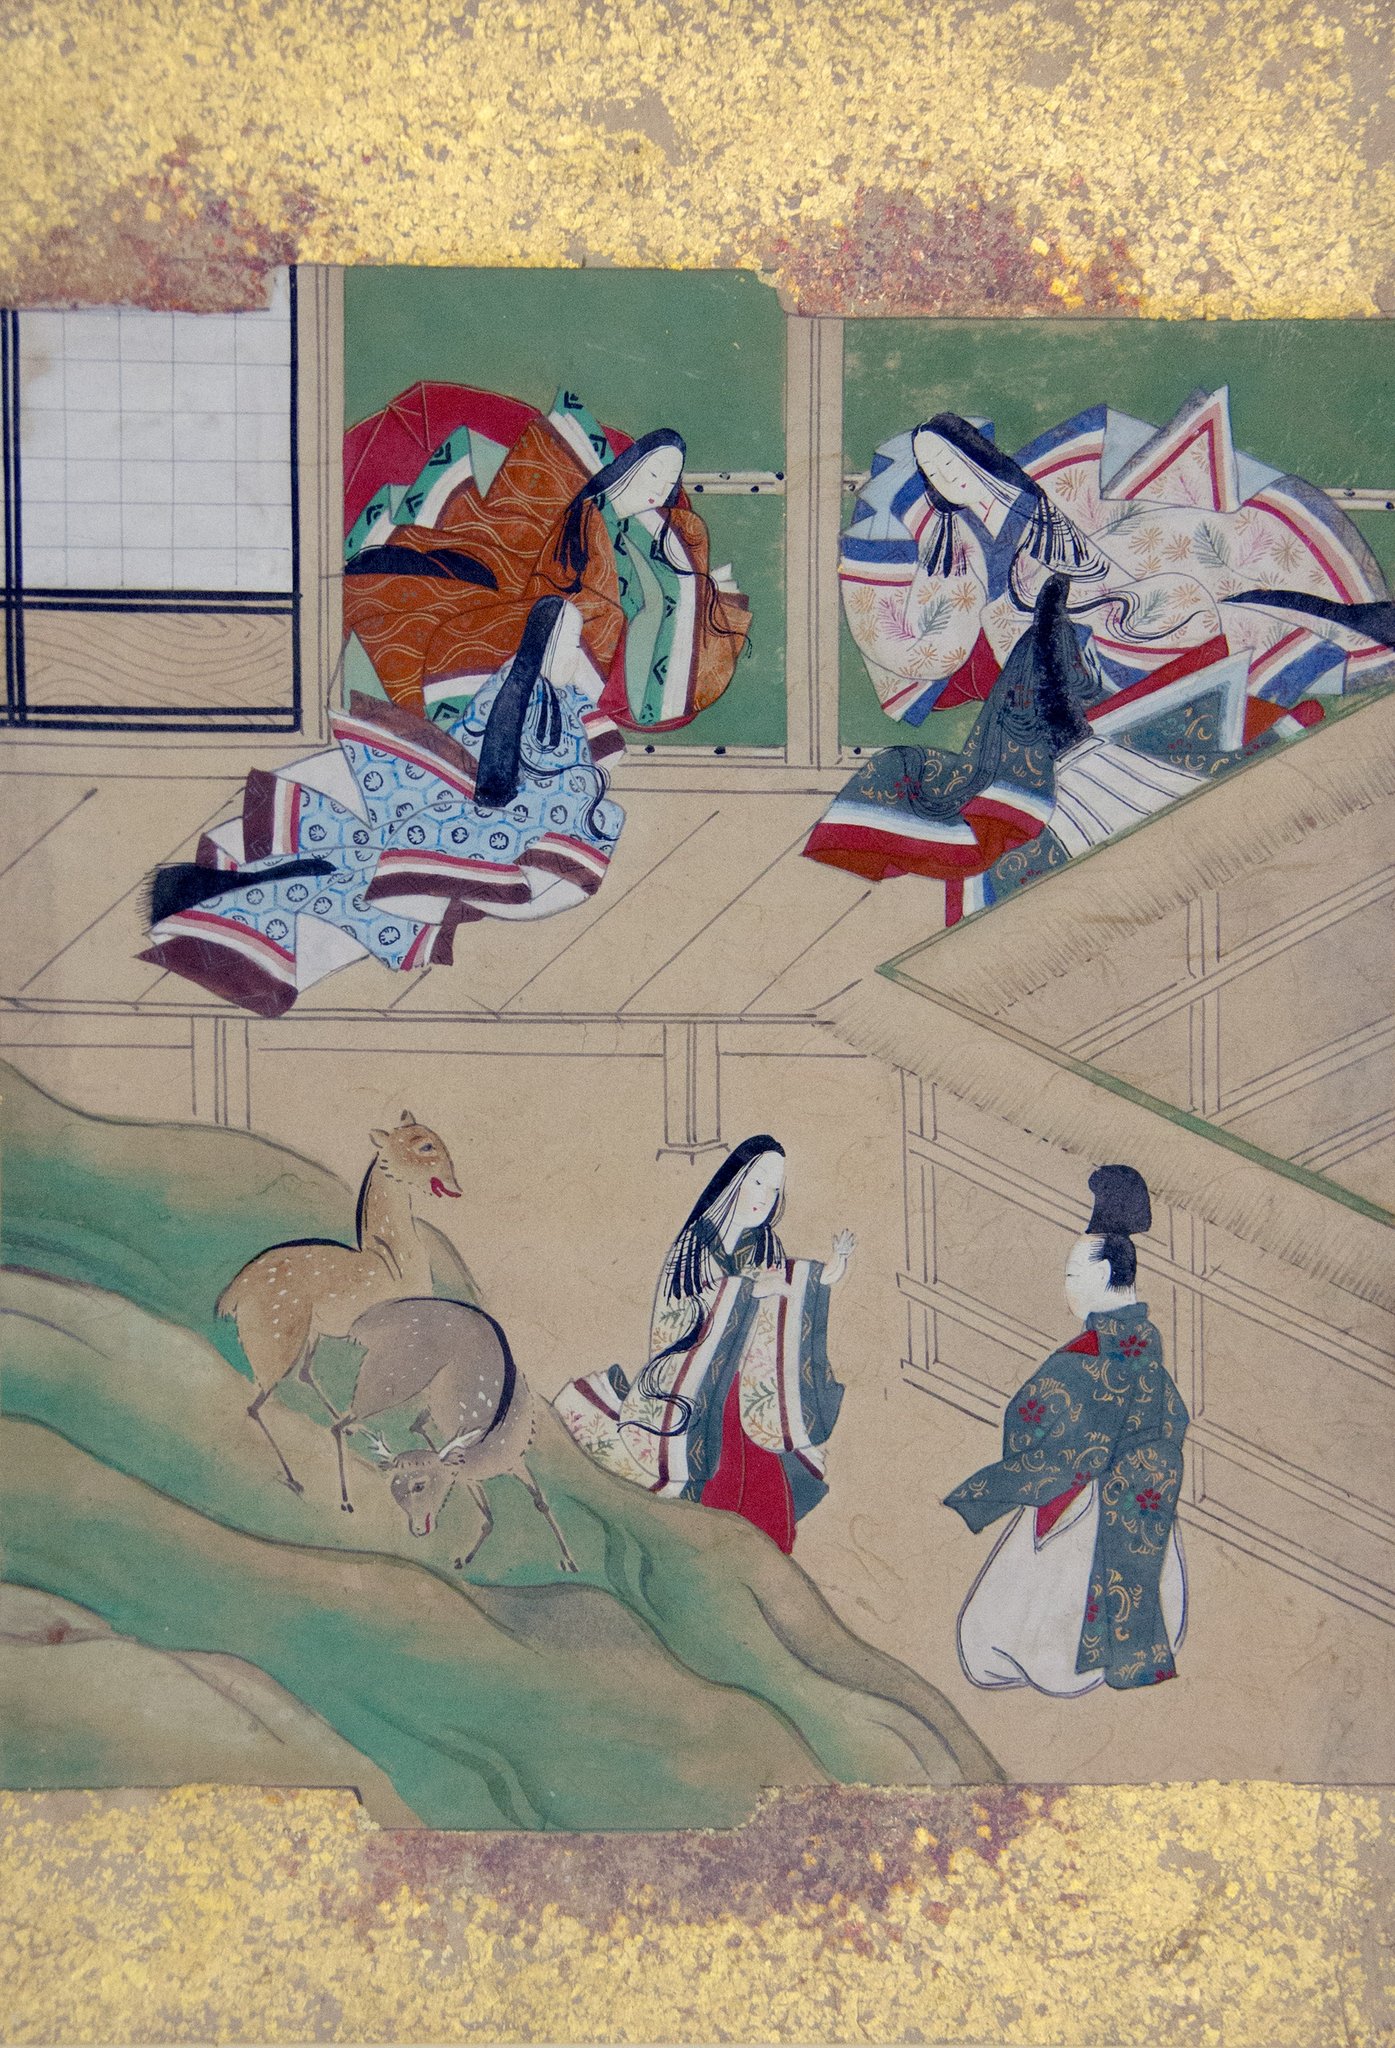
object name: album leaf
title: Scenes from Tales of Ise (Ise monogatari)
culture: japanese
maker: tosa school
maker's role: artist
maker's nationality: japanese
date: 1767-1800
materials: ink, paper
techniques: painting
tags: men,women,deer